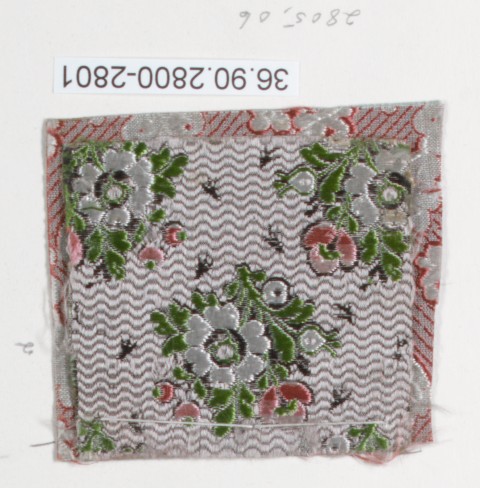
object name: piece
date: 1801-1900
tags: flowers